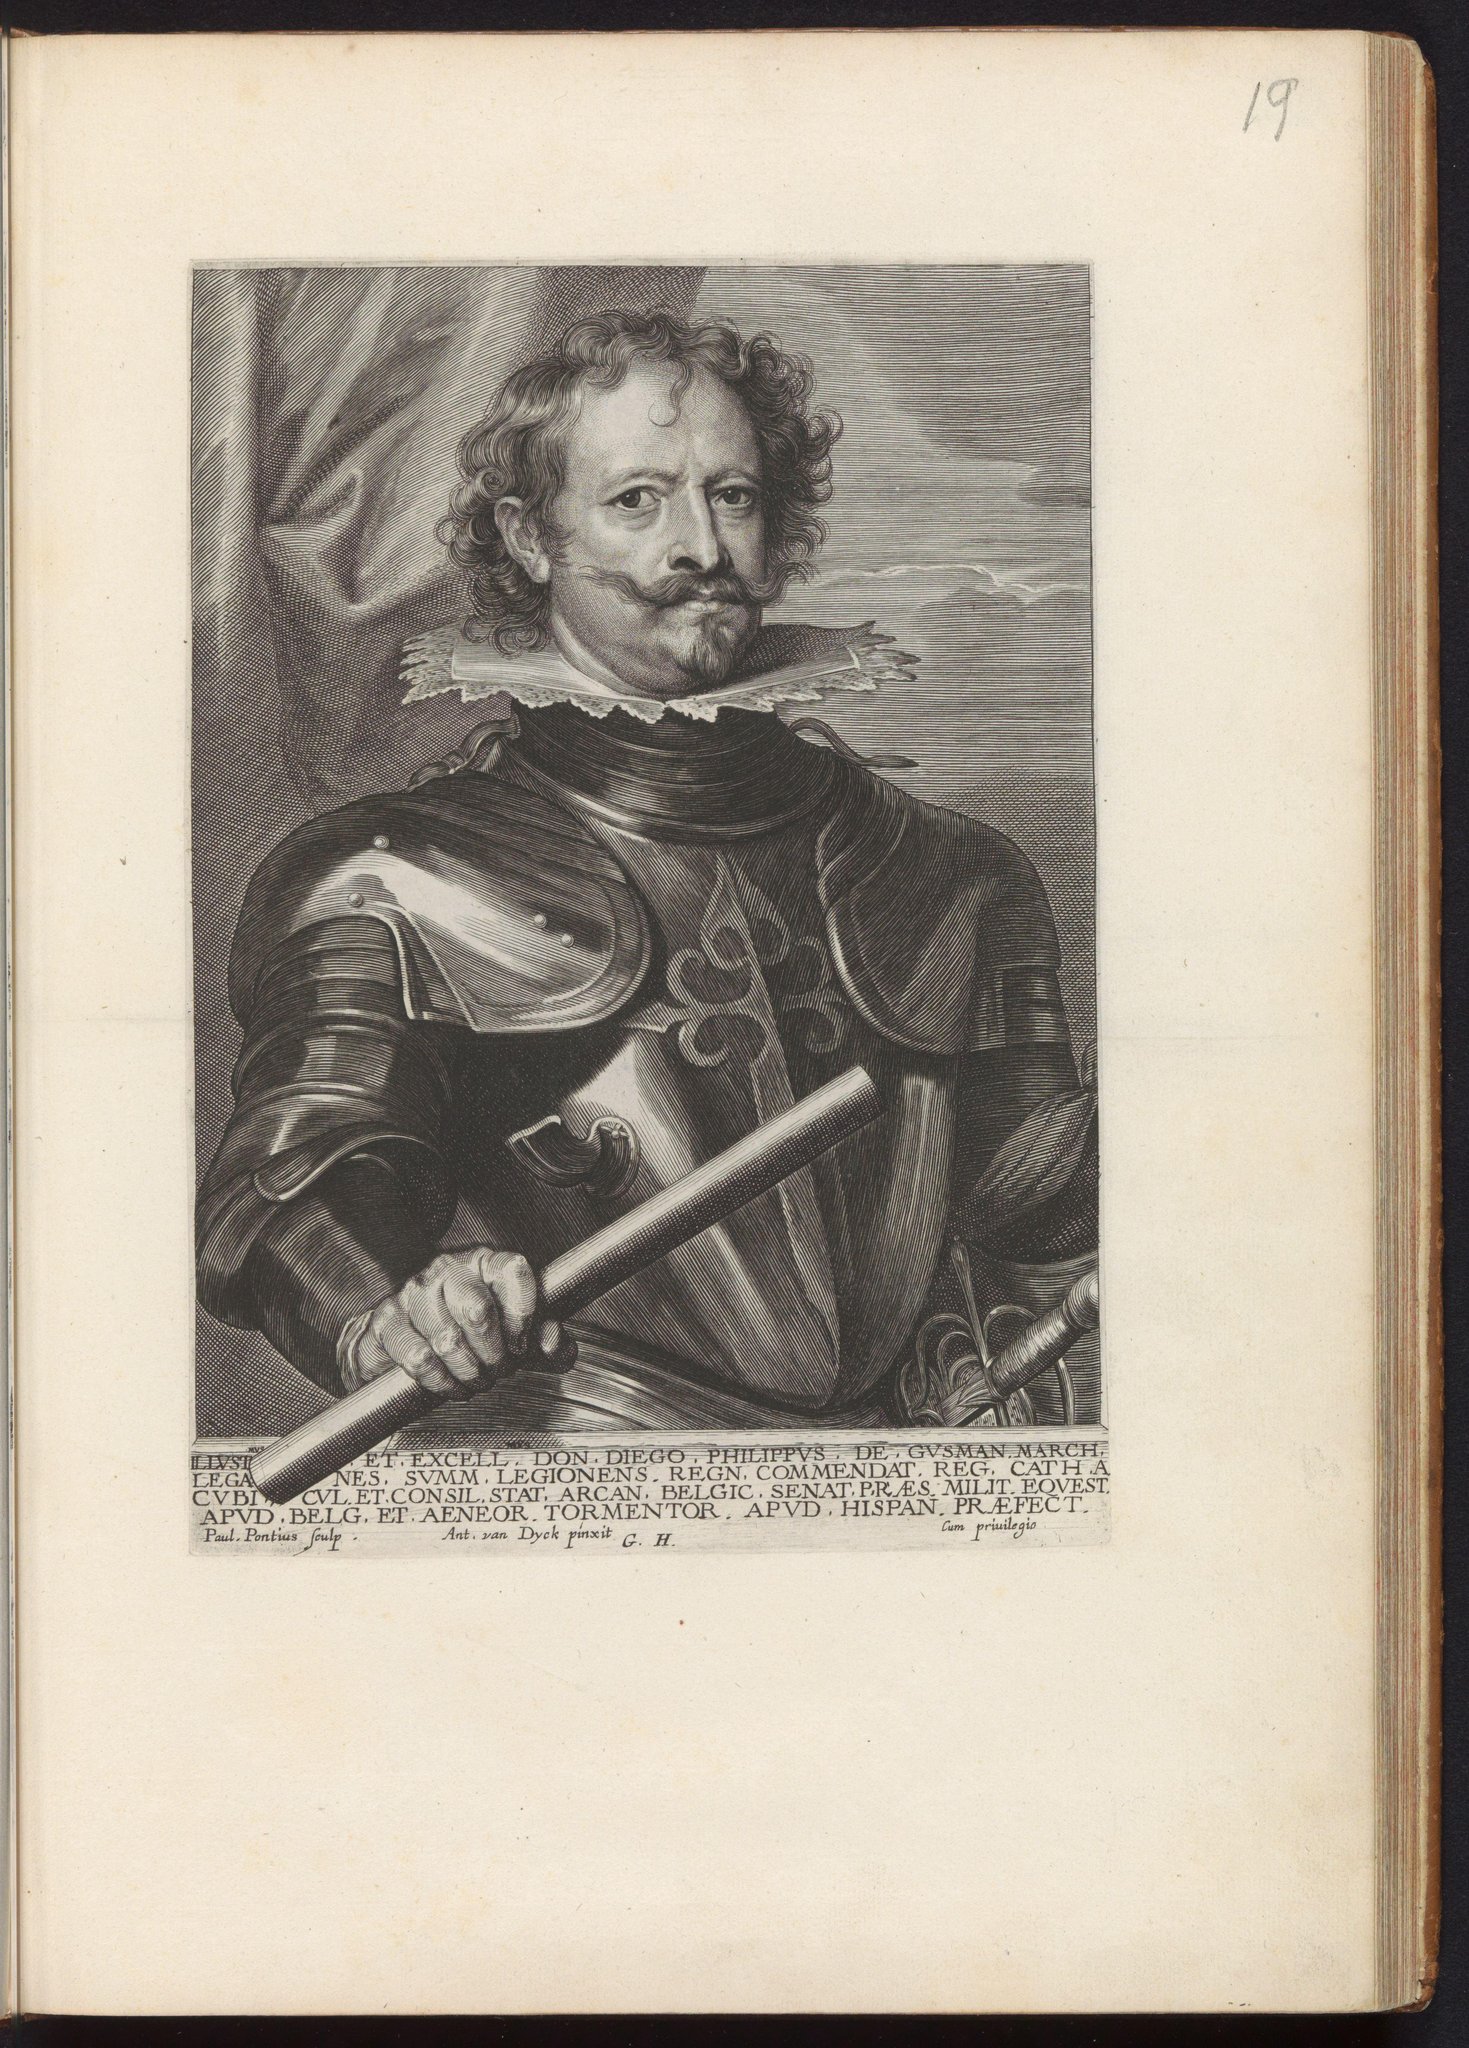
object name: album leaf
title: Portret van Diego Felipez de Guzmán, markies van Leganés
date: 1630-1641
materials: paper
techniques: engraving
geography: antwerp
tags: armour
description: Deze prent maakt deel uit van een album.